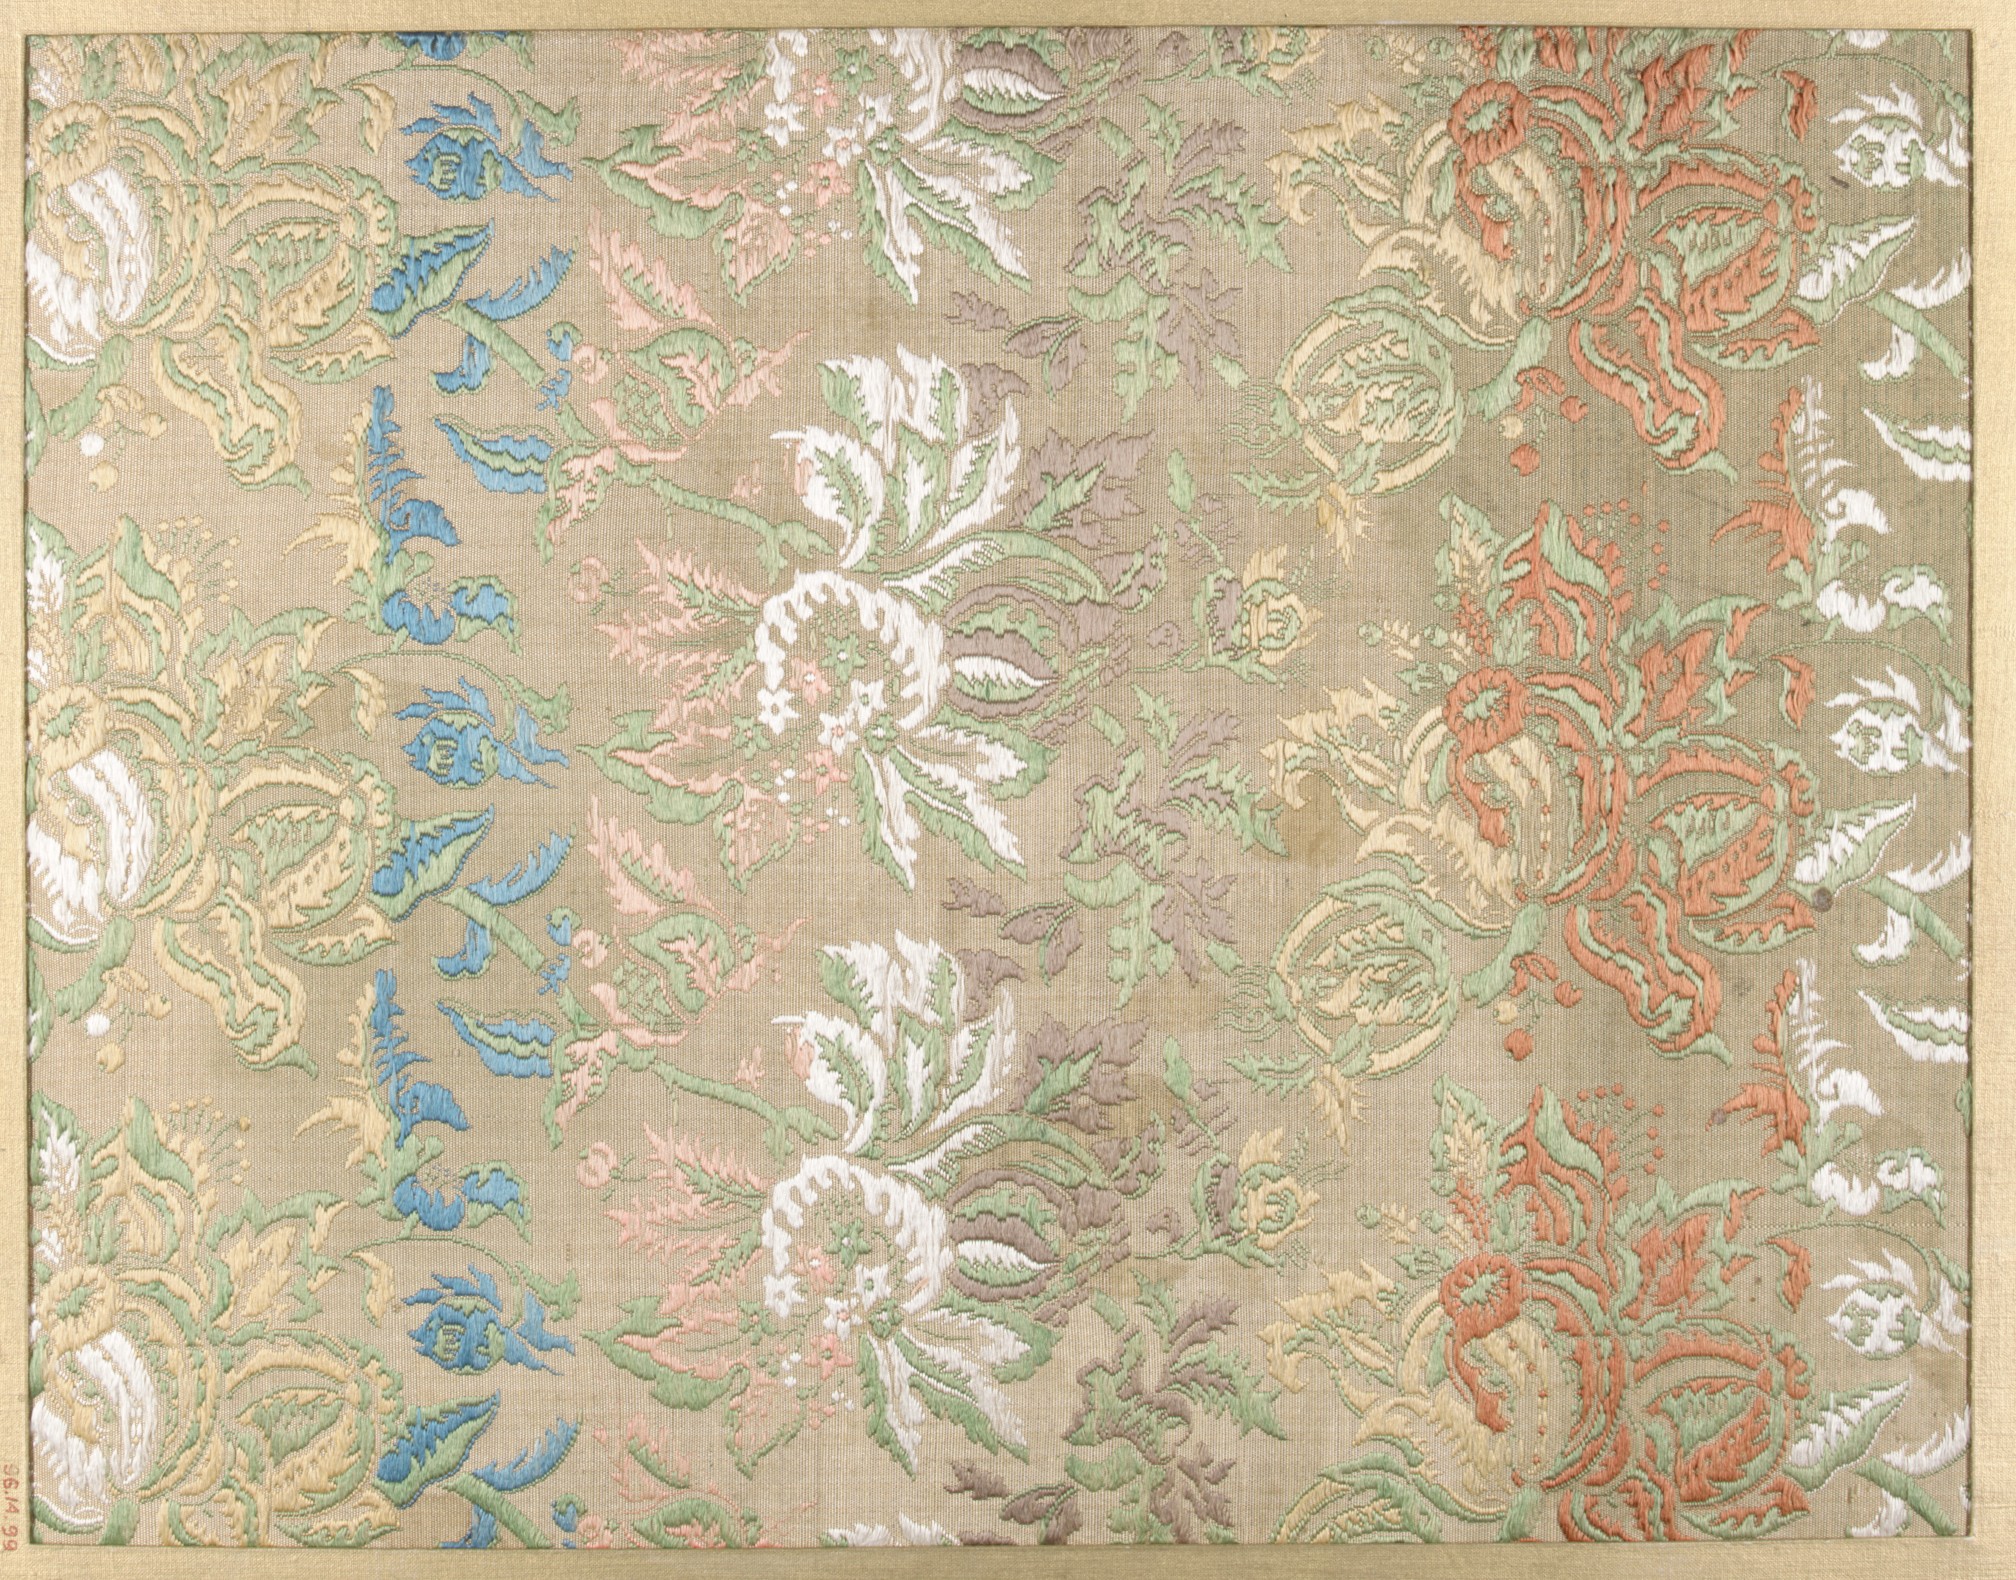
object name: piece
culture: japanese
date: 1701-1900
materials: silk